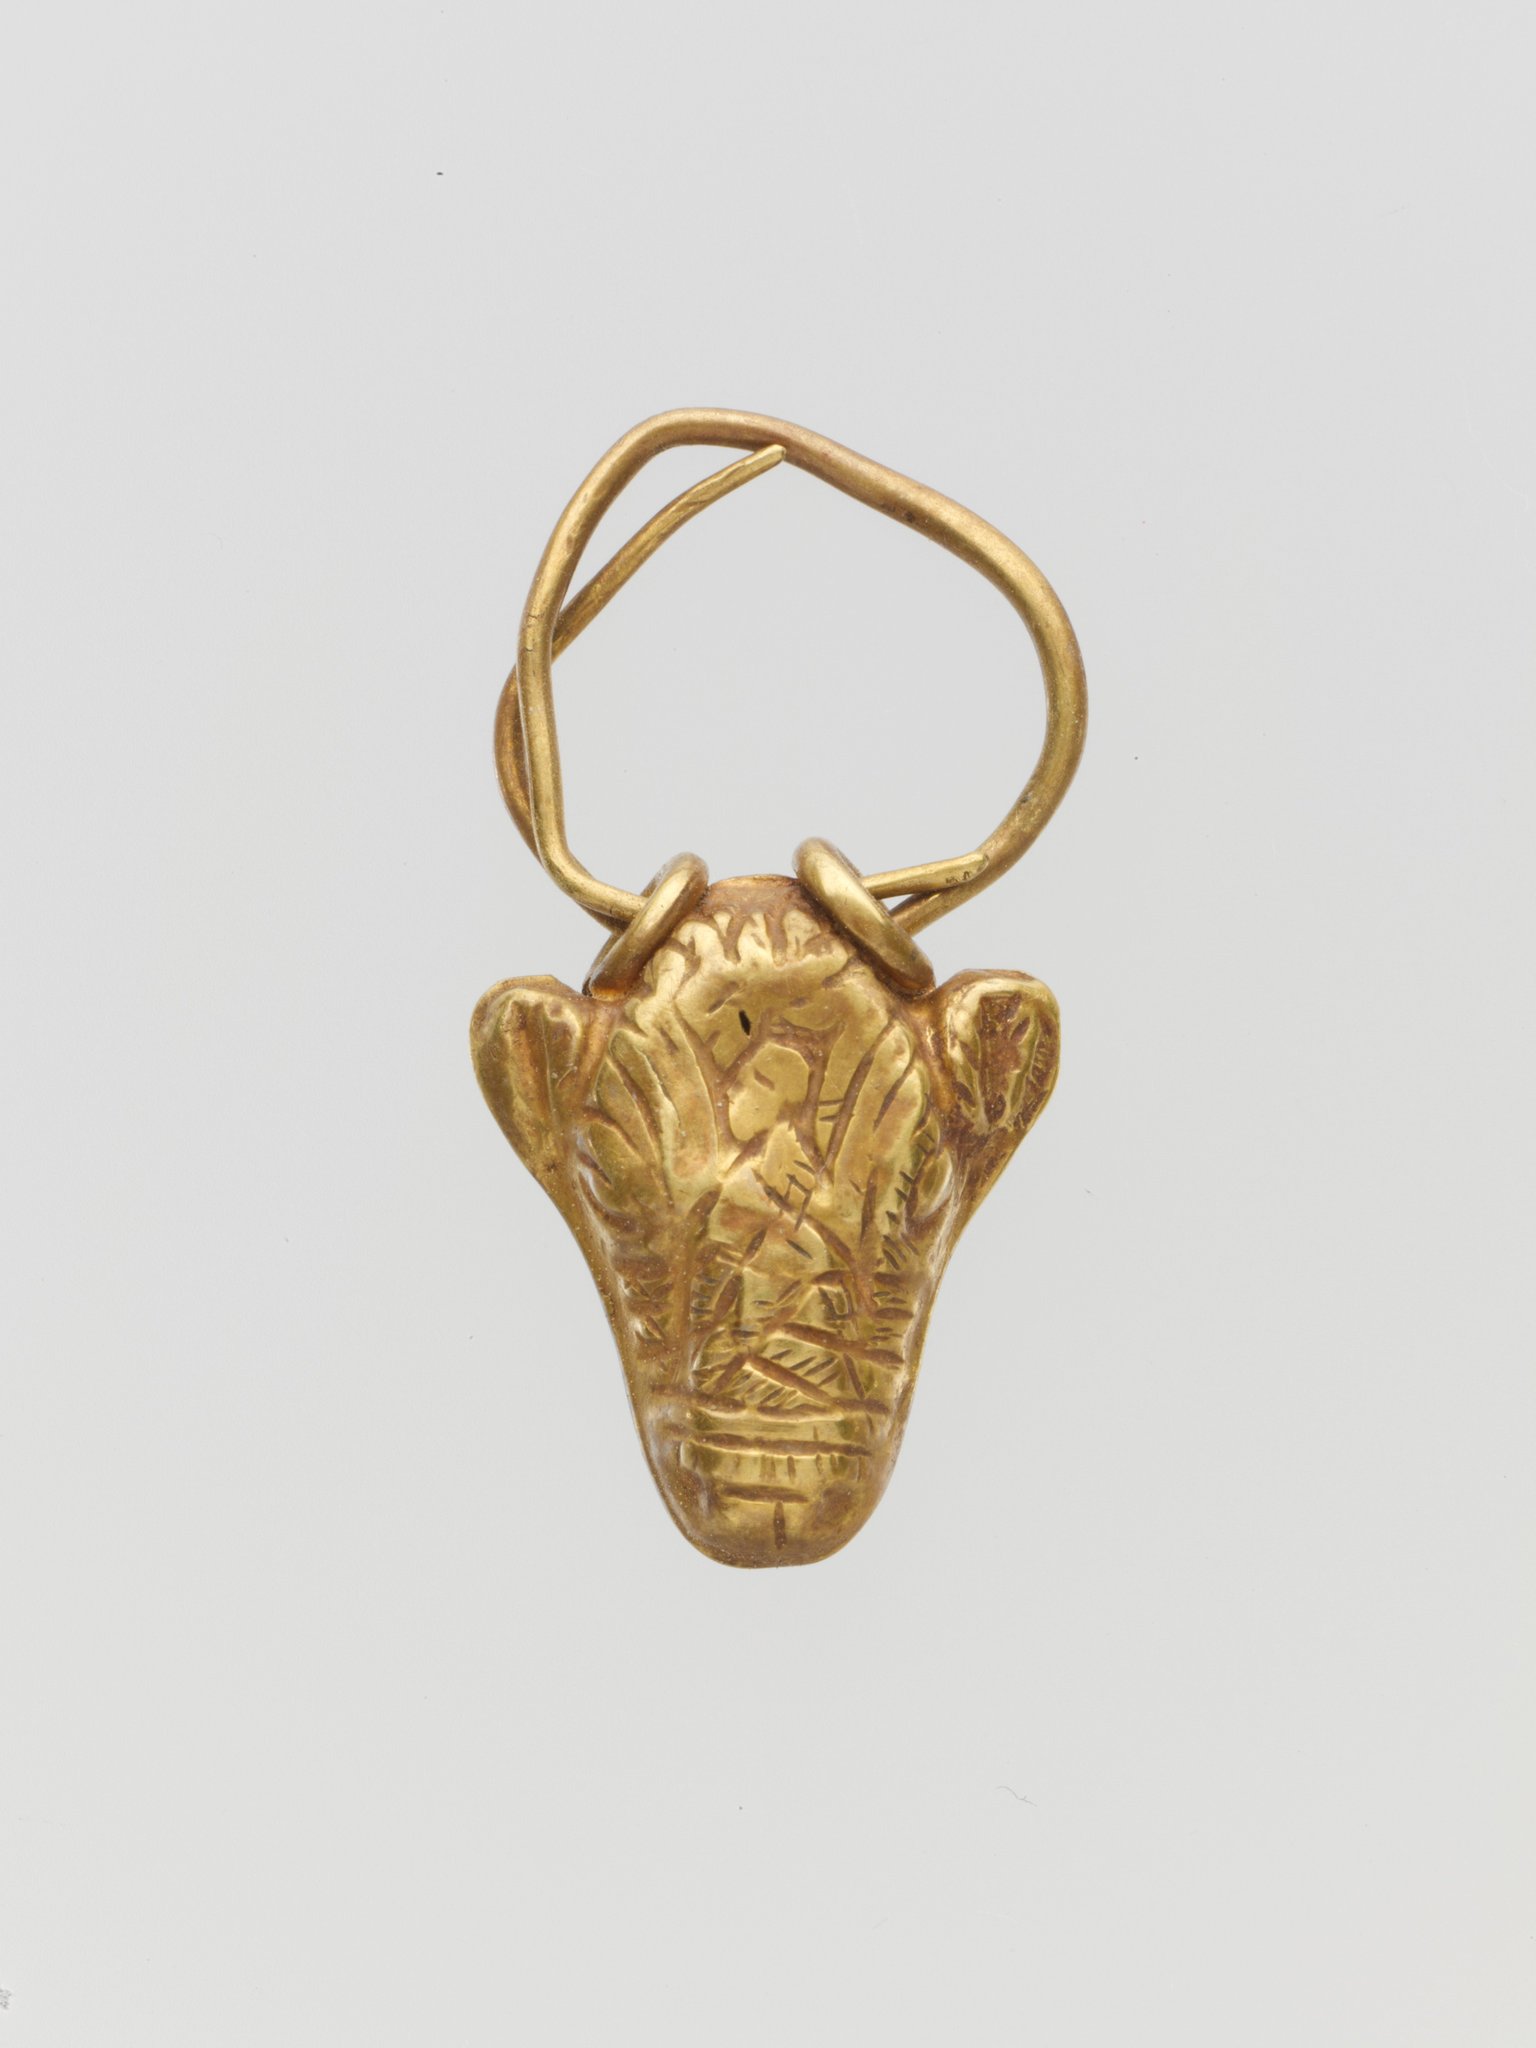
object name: earring with head of bull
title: Gold pendant in the form of a bull's head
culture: cypriot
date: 1400-1050 BCE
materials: gold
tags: bulls